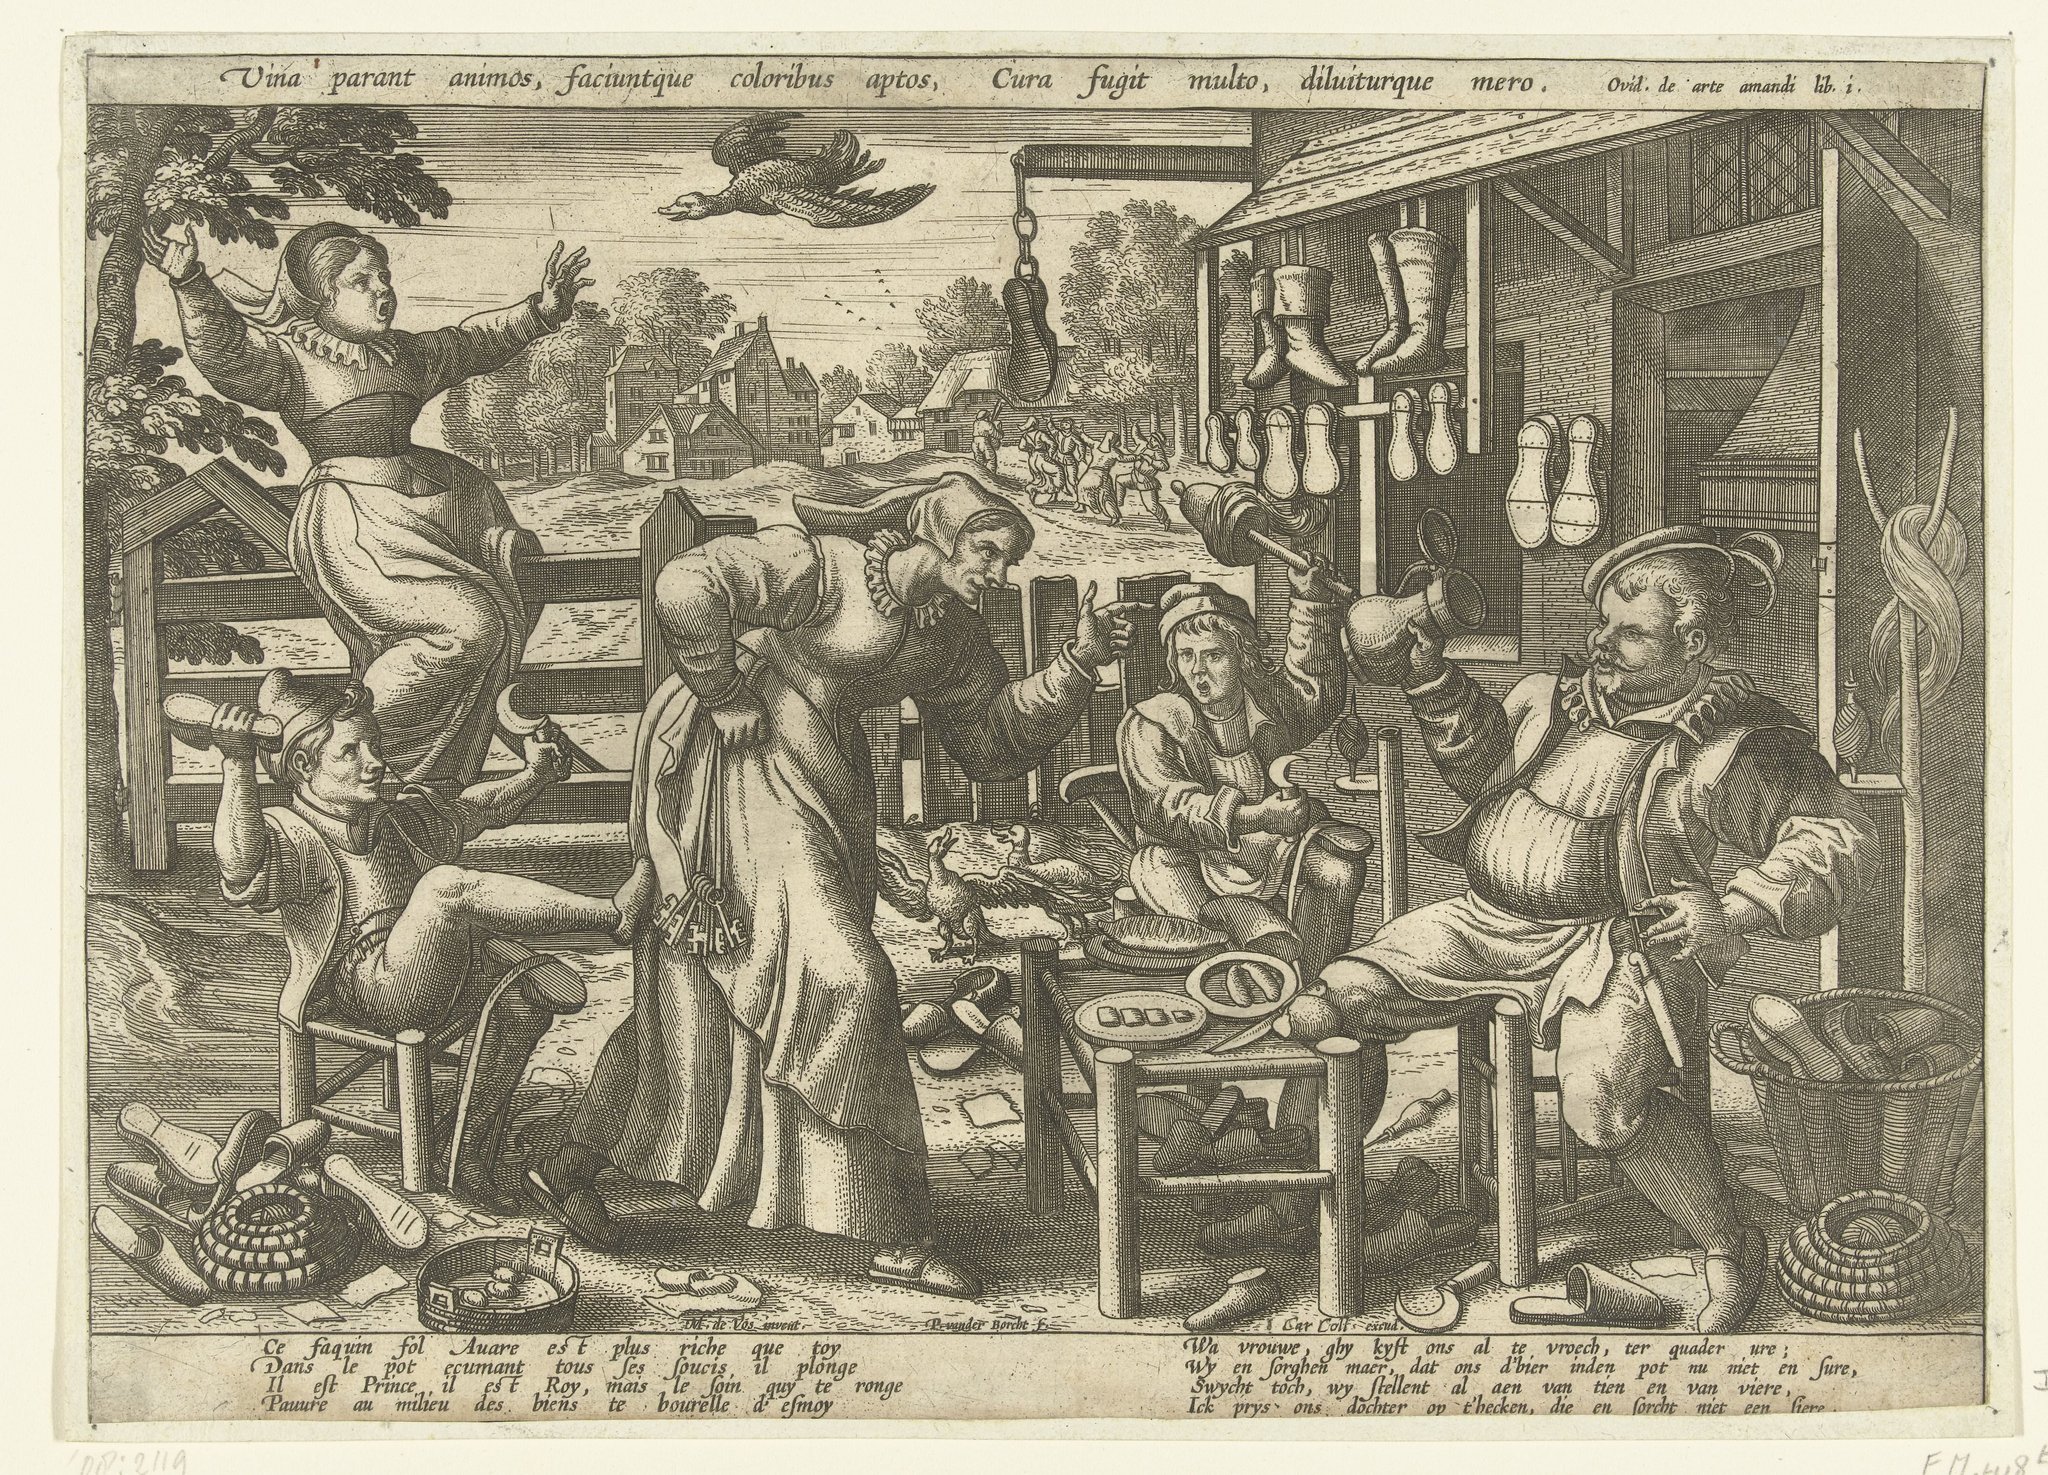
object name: print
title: Het bedorven huishouden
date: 1545-1608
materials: paper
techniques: engraving, etching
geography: antwerp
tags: more than one couple dancing, man and wife quarrelling, 'marriage à la mode', shoe-maker, cobbler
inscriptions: collector's mark: Lugt 2228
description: Schoenmaker voor zijn huis, zittend voor zijn werkbank. In plaats van te werken drinkt hij een pint bier. Zijn leerjongens, die schoenen maken, schoppen keet. De vrouw van de schoenmaker staat kijvend voor hem. Zijn dochter zit al roepend op een hek. Op de achtergrond dansen boeren op de muziek van een doedelzak. Met bovenschrift van een regel in het Latijn en onderschrift van 2 kolommen van elk 4 regels in het Frans en Nederlands.